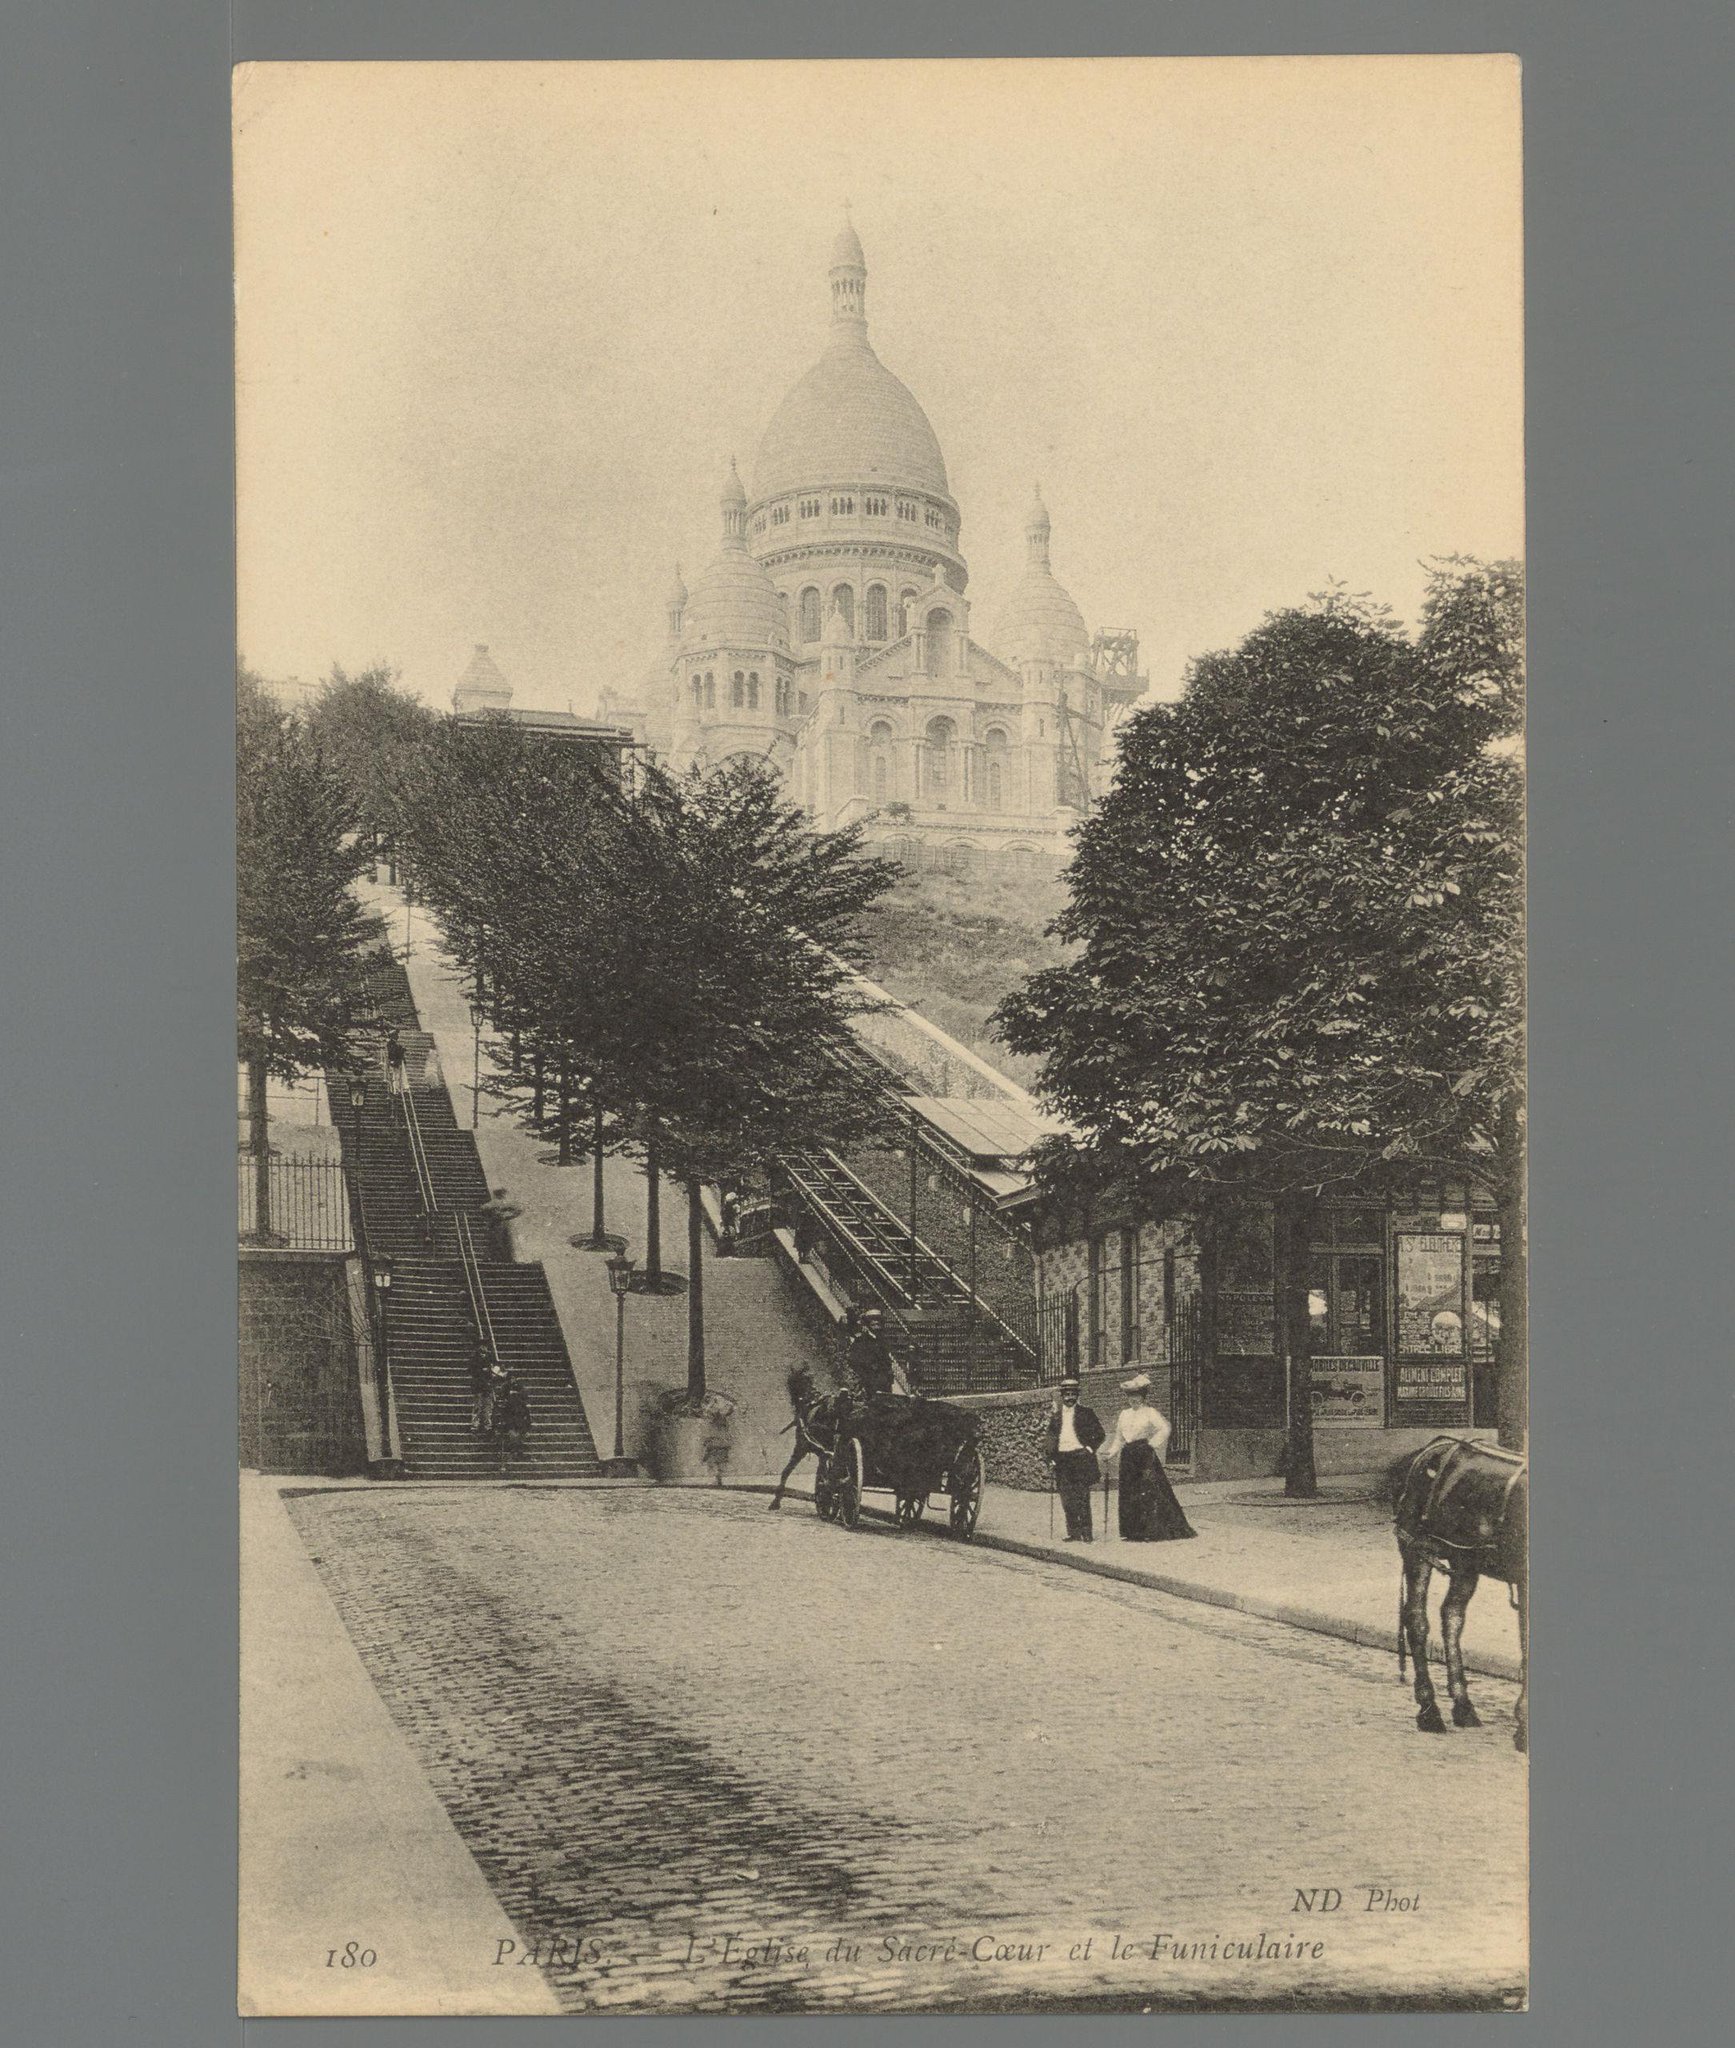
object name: ansichtkaart, prentbriefkaart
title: Paris. L'Église du Sacré-Coeur et le Funiculaire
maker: Anonymous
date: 1904-1906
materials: cardboard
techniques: photograph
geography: paris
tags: sloping street; street with steps or stairs, church (exterior), city-view, and landscape with man-made constructions (+ city(-scape) with figures, staffage)